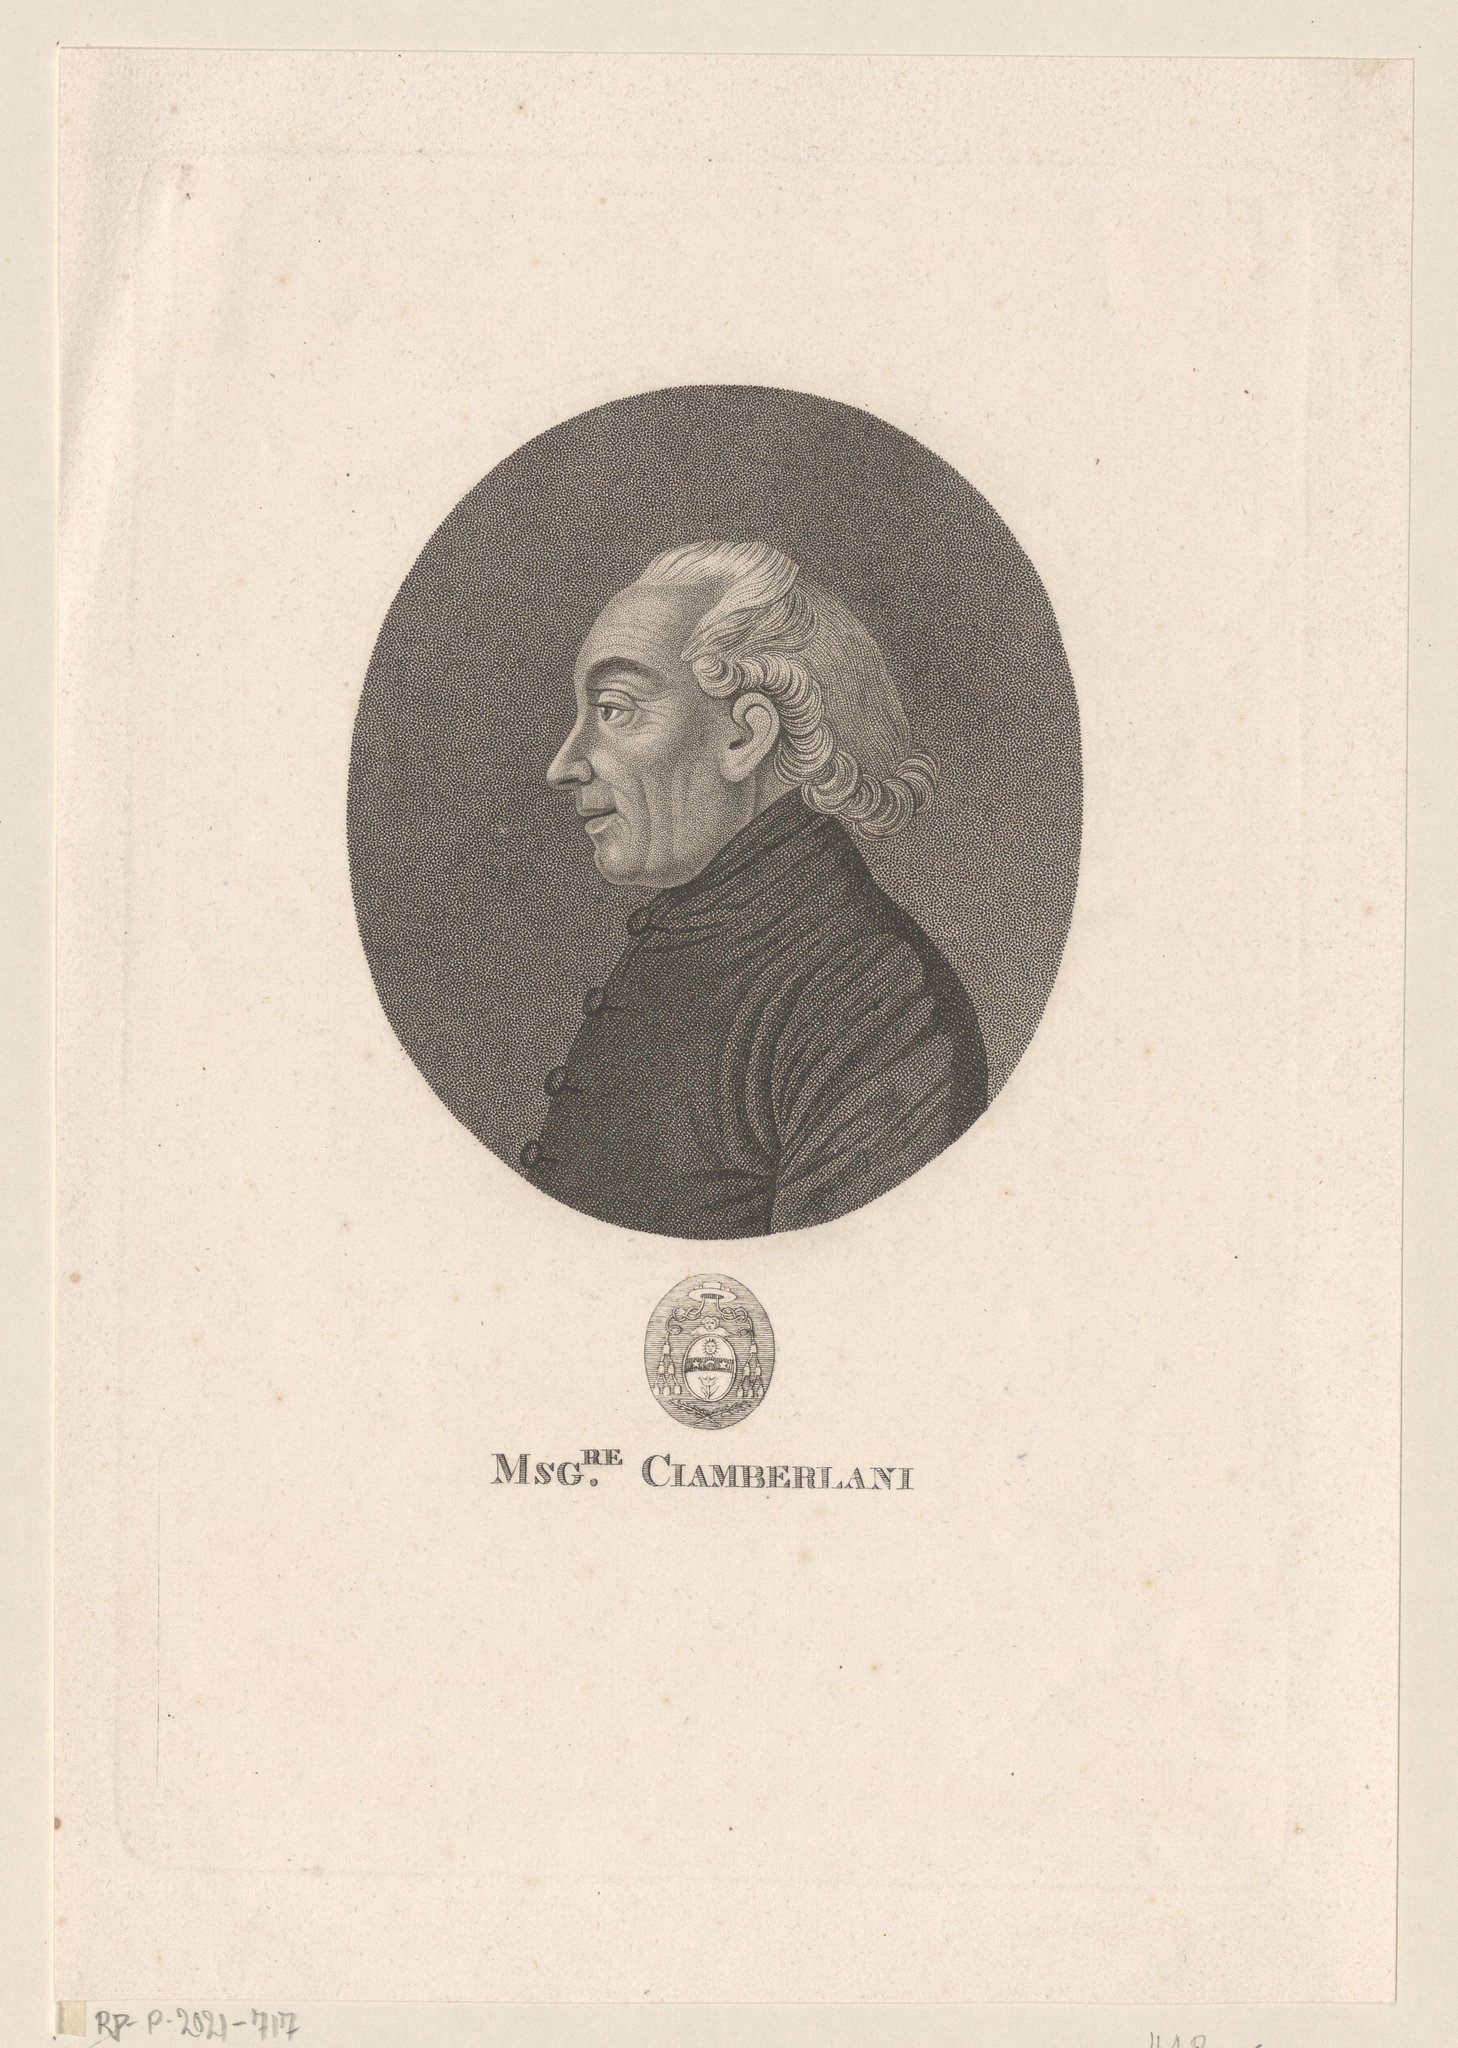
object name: print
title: Portret van Aloysius Ciamberlani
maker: Anonymous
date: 1795-1849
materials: paper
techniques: engraving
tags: historical persons, armorial bearing, heraldry